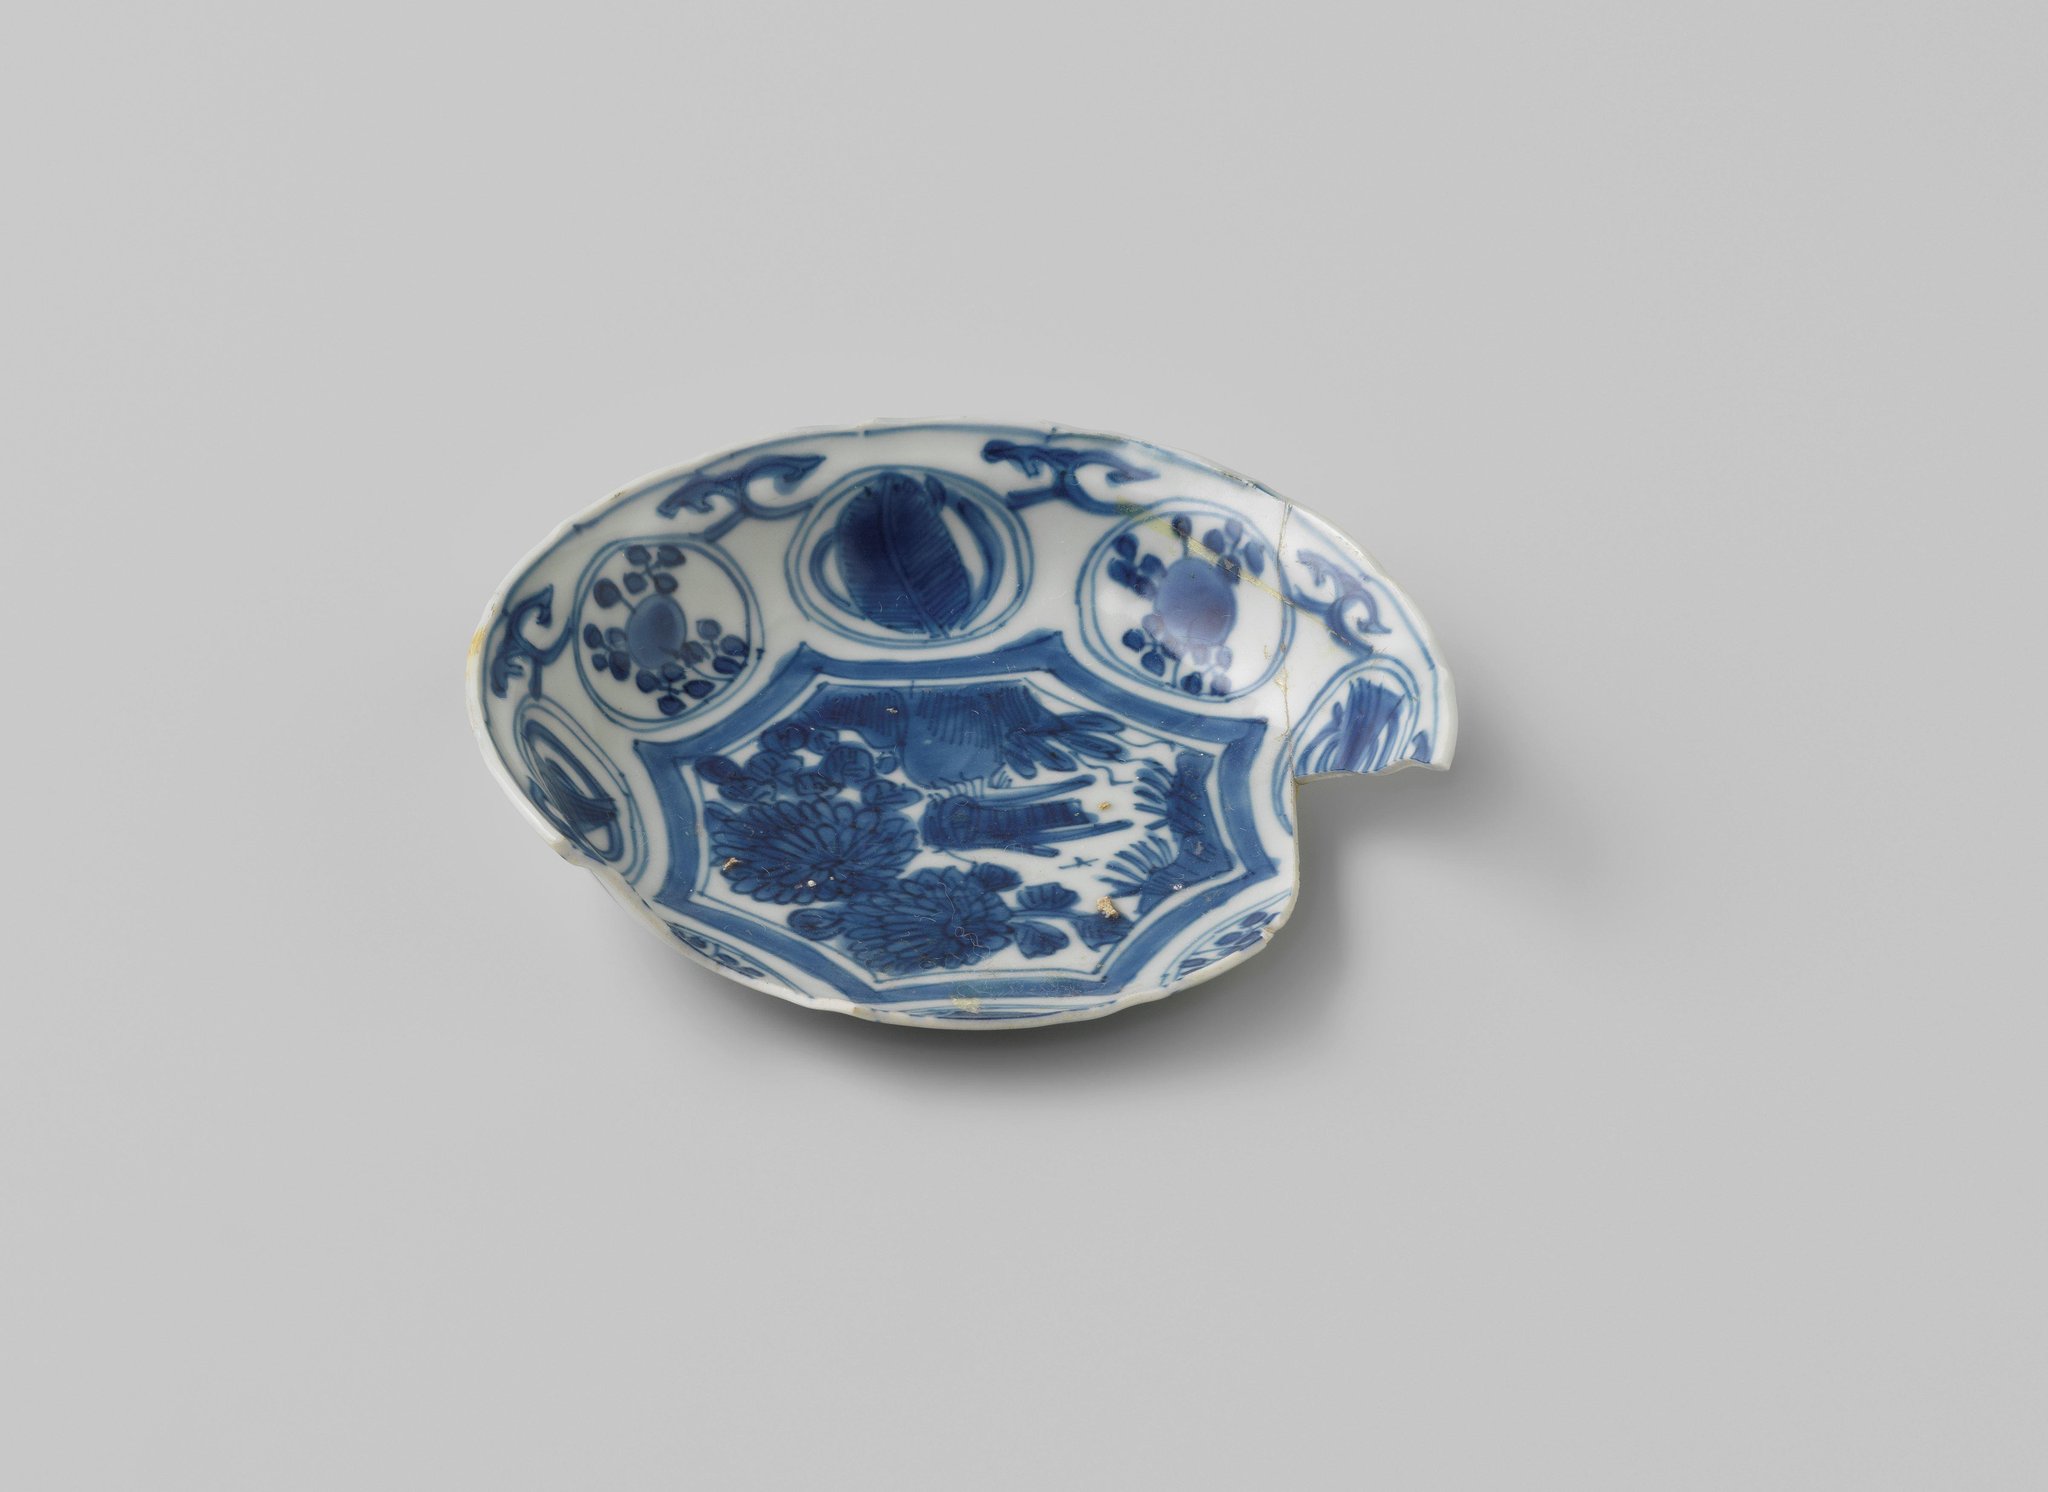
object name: plate dish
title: Fragment bord uit V.O.C.-schip de 'Witte Leeuw'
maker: Anonymous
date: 1613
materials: bone china, porcelain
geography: jingdezhen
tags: verenigde oostindische compagnie, sint-helena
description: A saucer without a flattened rim. A central decoration of a grasshopper on a rock and a chrysanthemum. The medallions decorated with peaches and symbols.